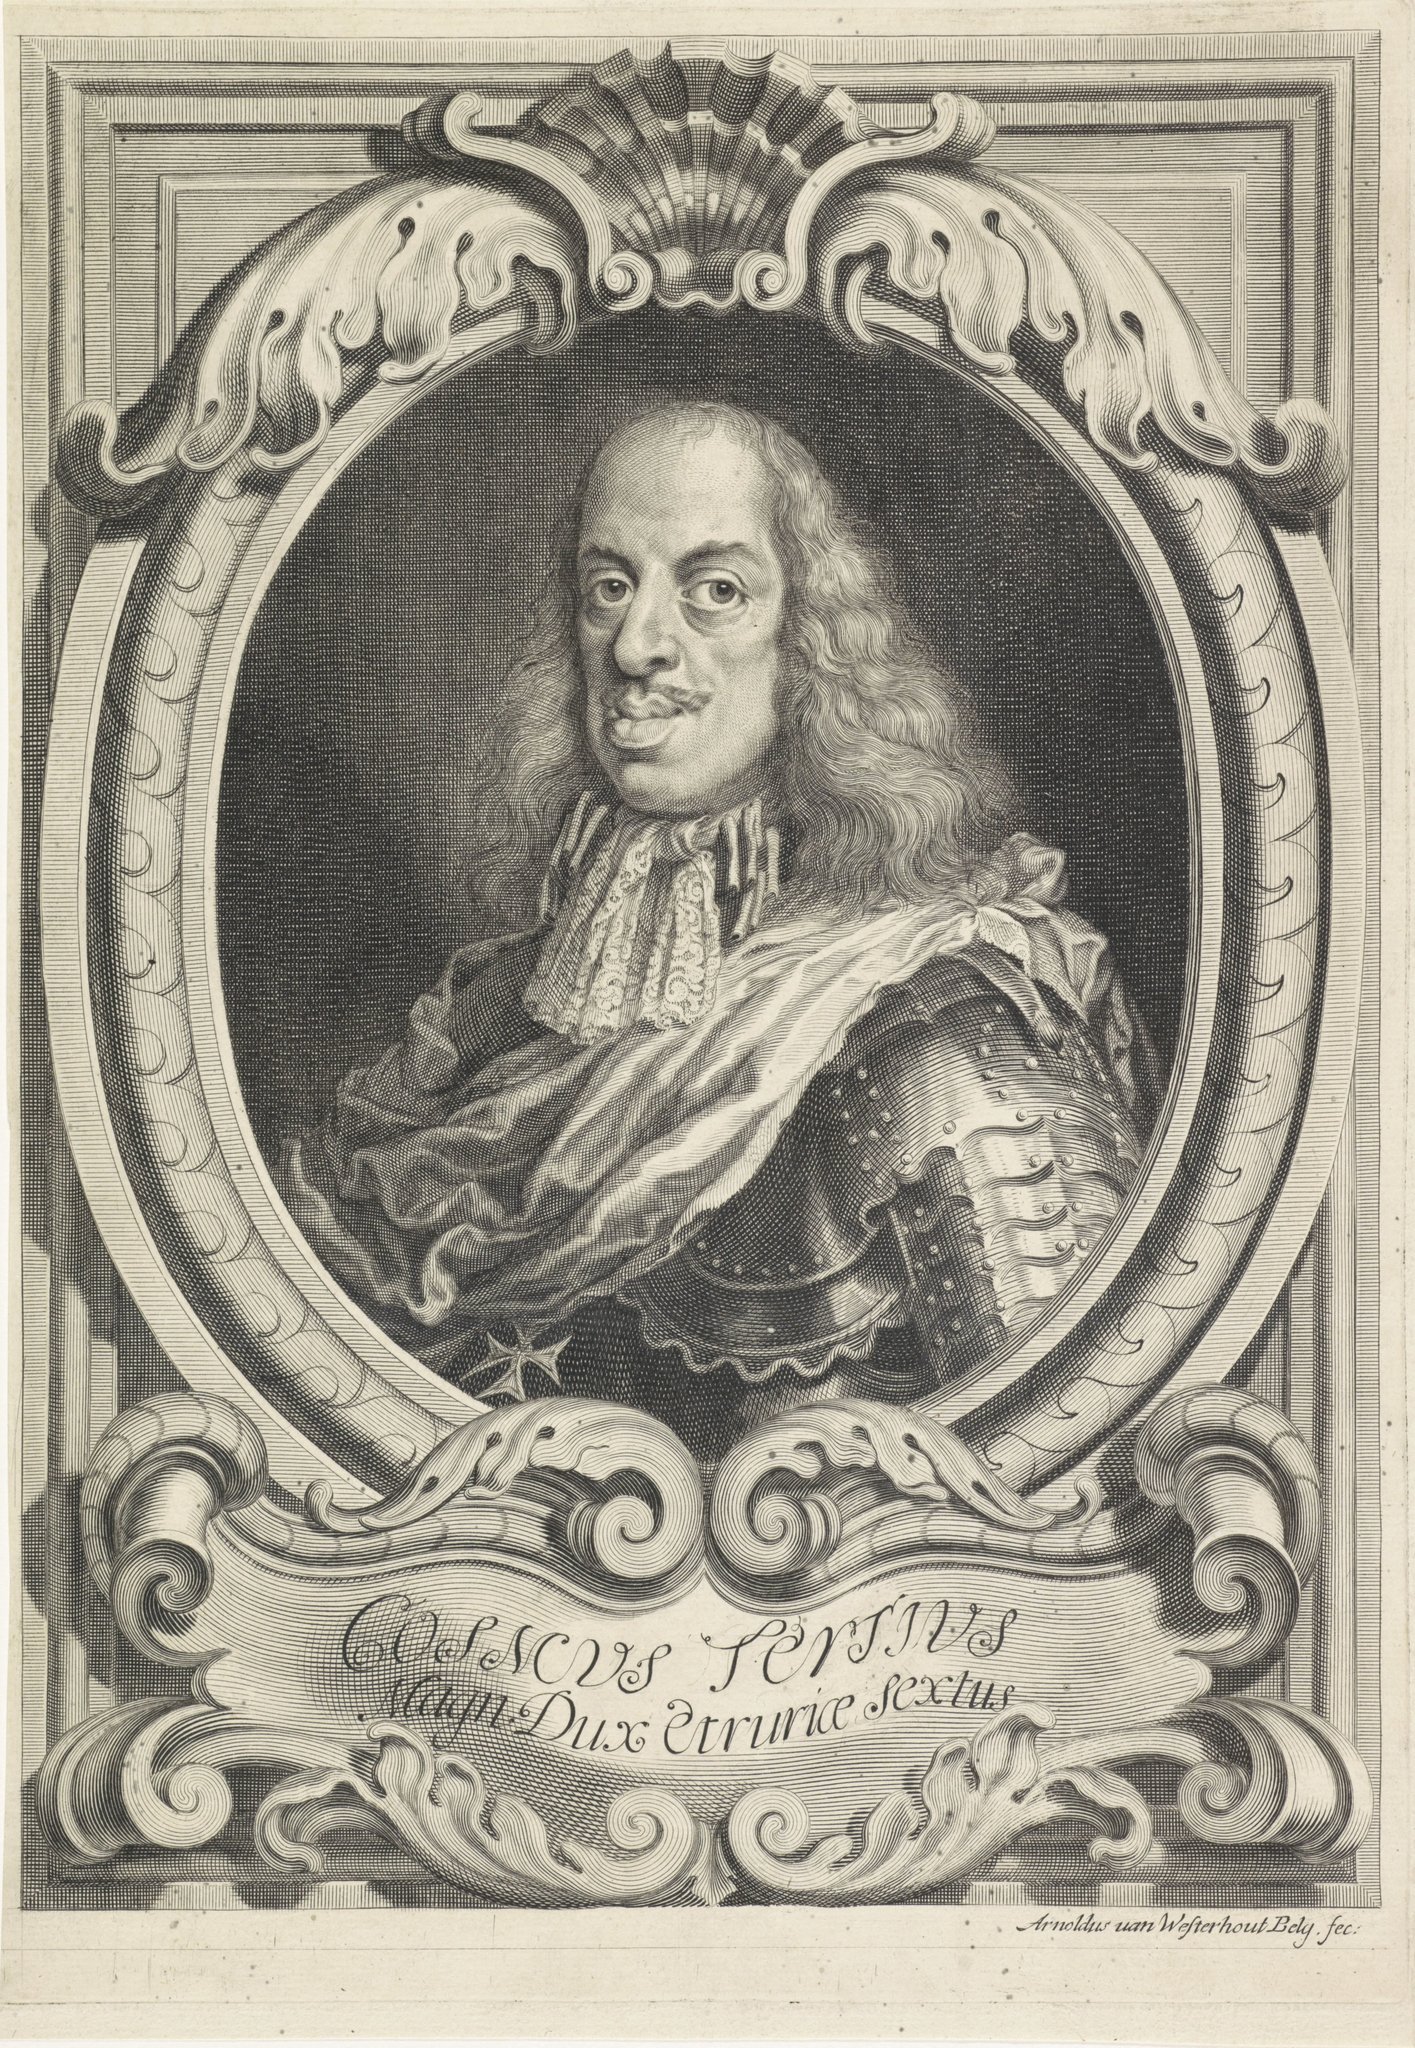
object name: print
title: Portret van Cosimo III de' Medici, groothertog van Toscane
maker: arnold van westerhout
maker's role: print maker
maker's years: 1651-1725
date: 1665-1725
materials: paper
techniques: engraving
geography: italy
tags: cosimo iii de' medici, knighthood order, armour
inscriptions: collector's mark: Lugt 2228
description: Hij draagt een harnas en de Orde van de heilige Stefanus. In de cartouche onder zijn portret zijn naam en functie in het Latijn.